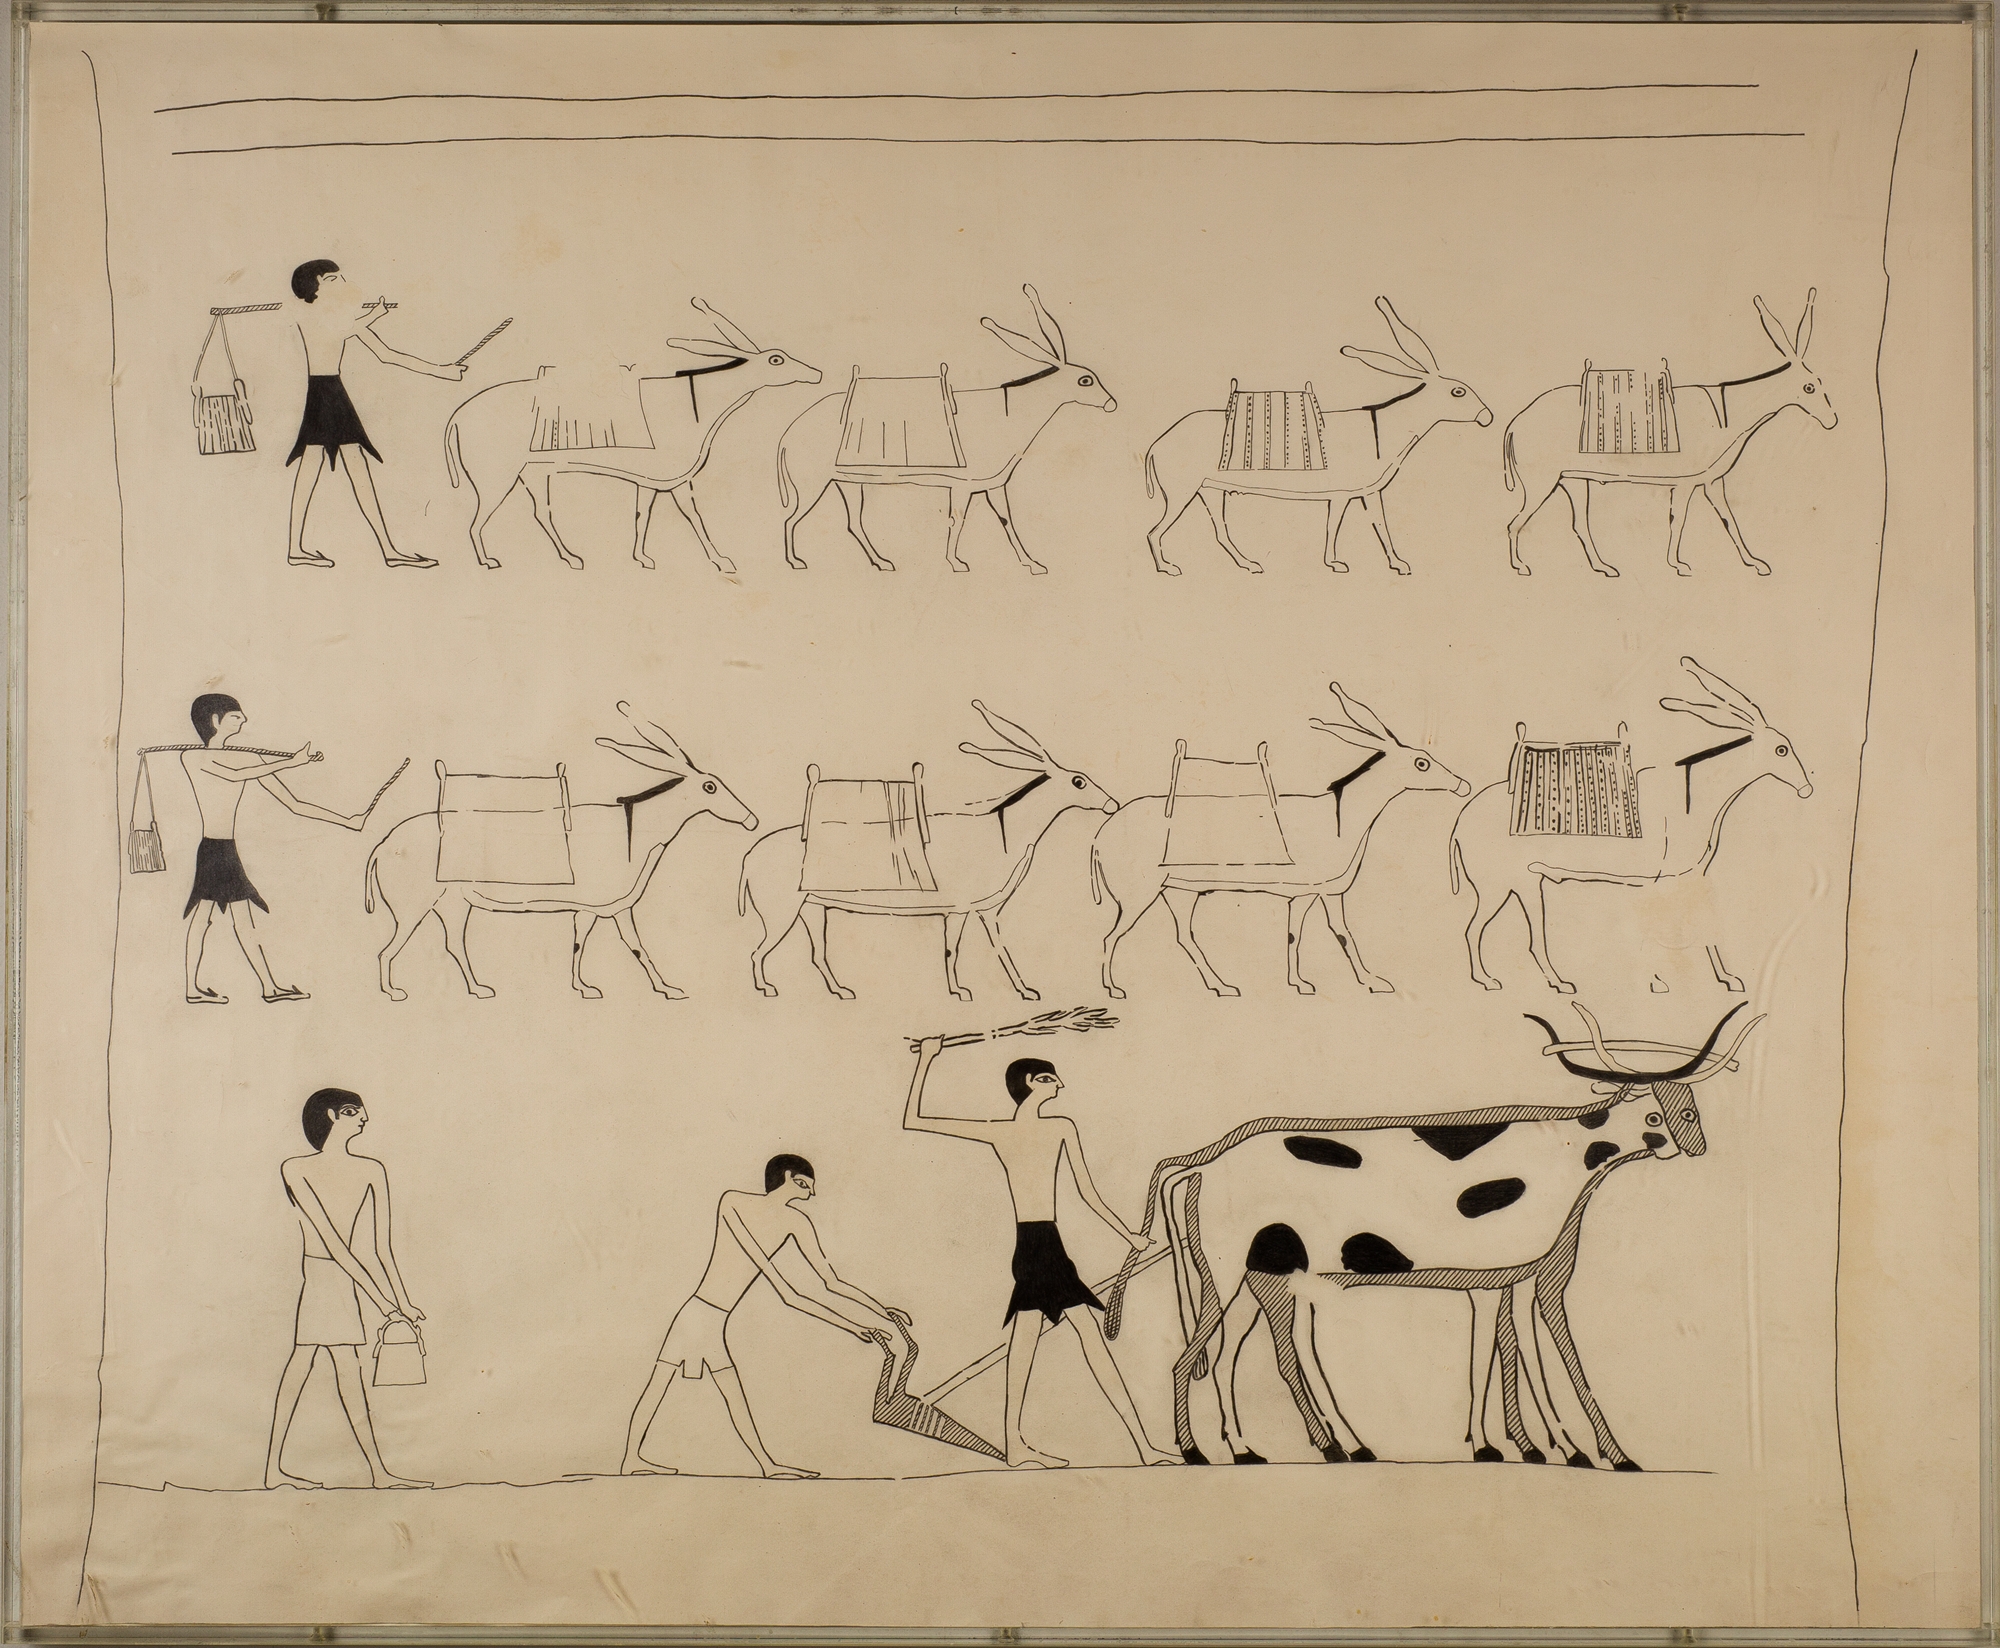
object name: facsimile, djari tt 366, plowing, donkey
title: Laden Donkeys and Men Plowing, Tomb of Djari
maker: unknown copyist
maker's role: artist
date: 2050-2000 BCE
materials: ink, paper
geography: egypt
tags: men,cows,donkeys,working